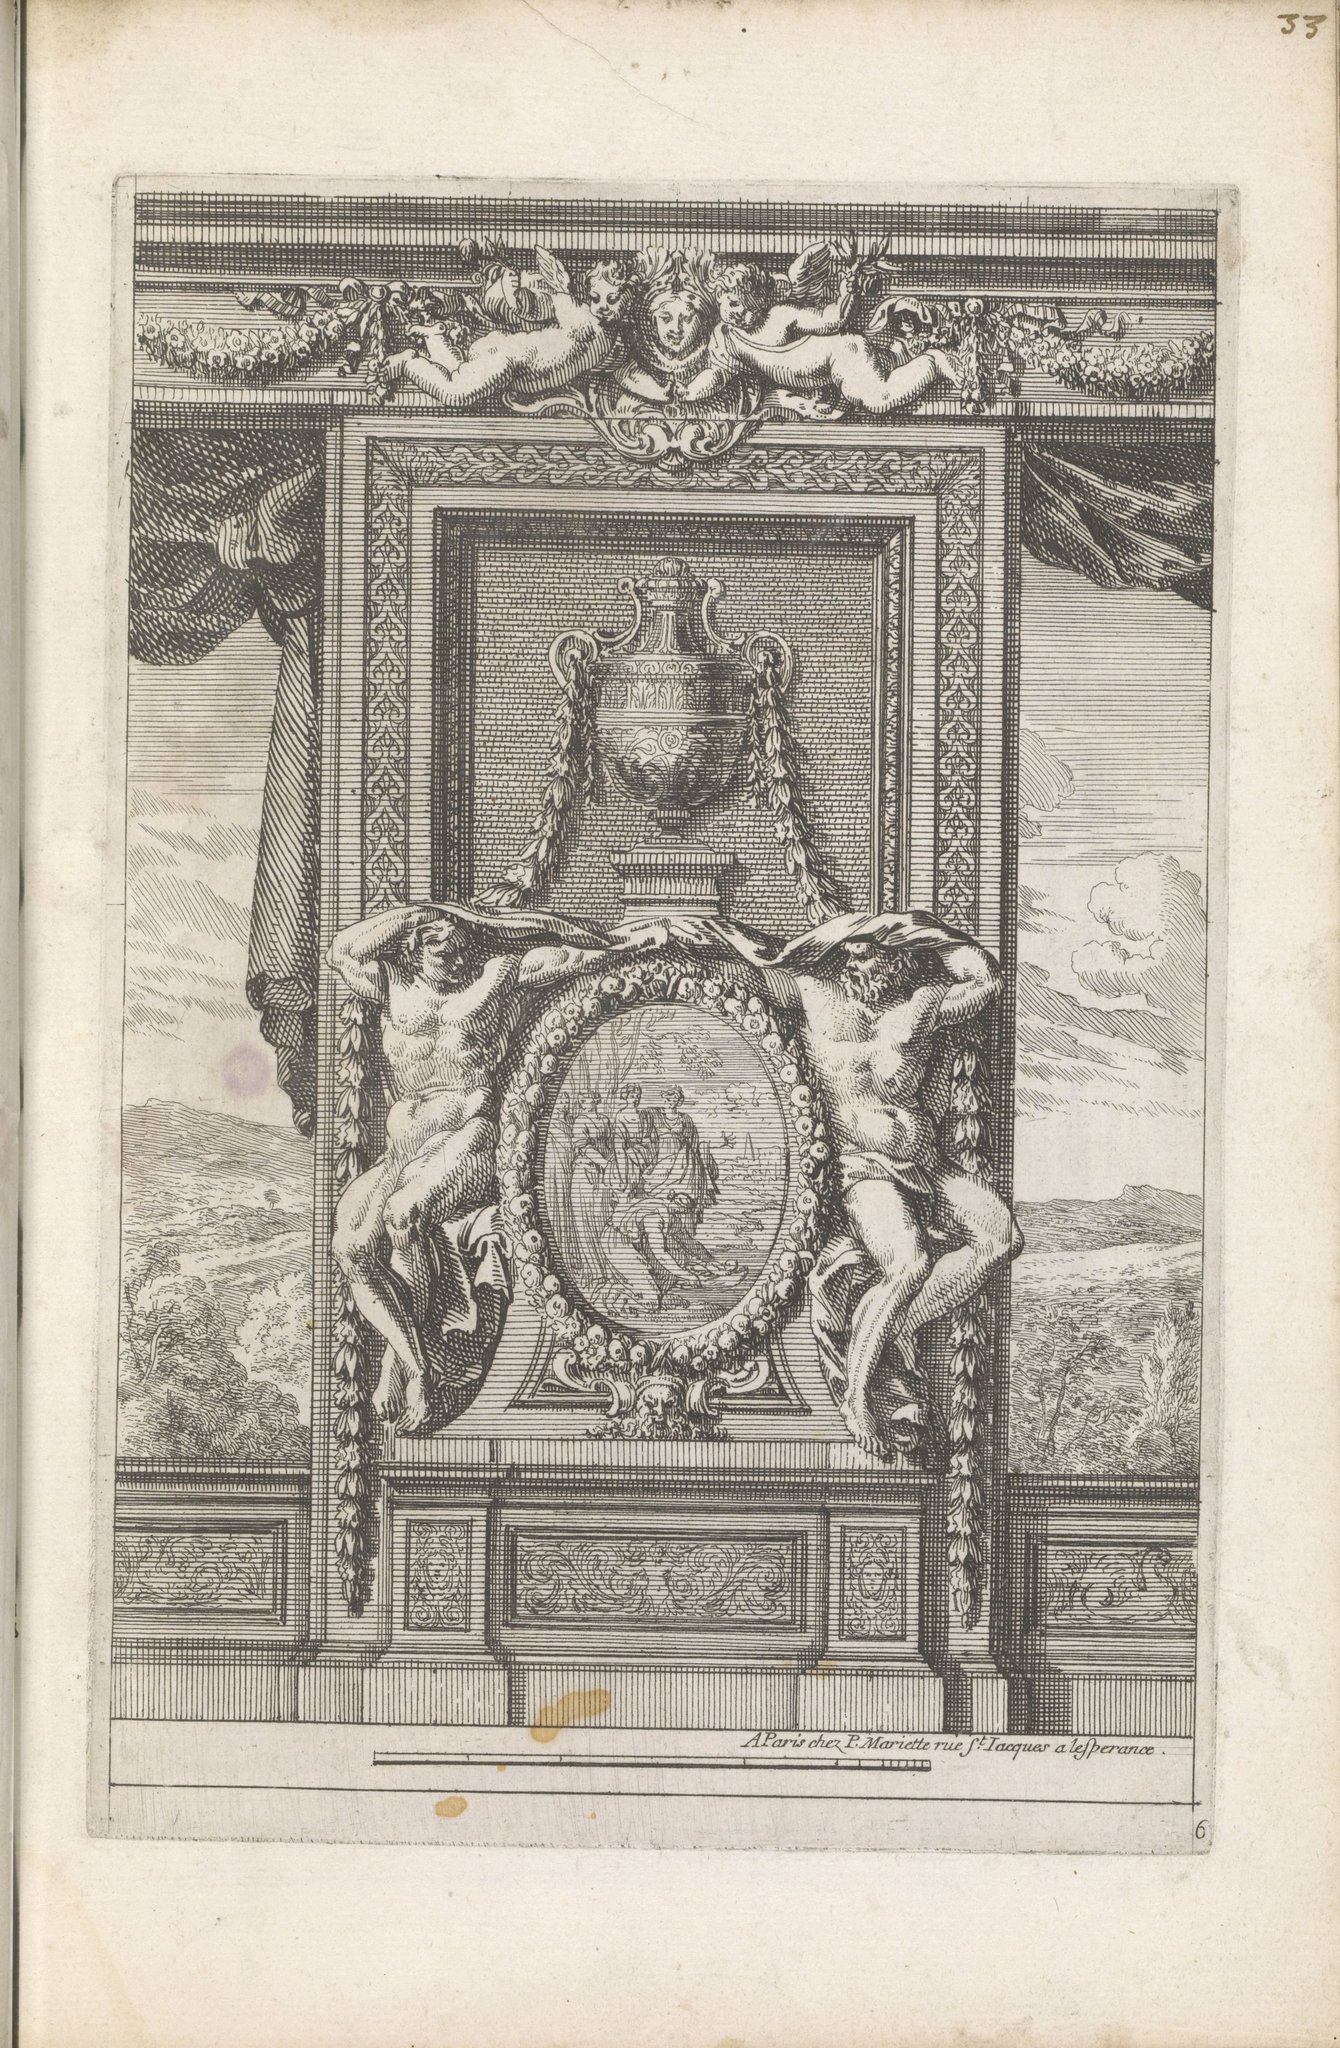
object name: ornament print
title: Muurpaneel met een voorstelling van Mozes die gevonden wordt door de dochter van de farao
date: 1659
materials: paper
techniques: etching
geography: paris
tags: ornaments ~ art, panelling, the finding of moses: pharaoh's daughter comes to bathe with her maidens in the river and discovers the child floating on the water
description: Muurpaneel met een ovale voorstelling van Mozes die gevonden wordt door de dochter van de farao. Prent maakt deel uit van een album.